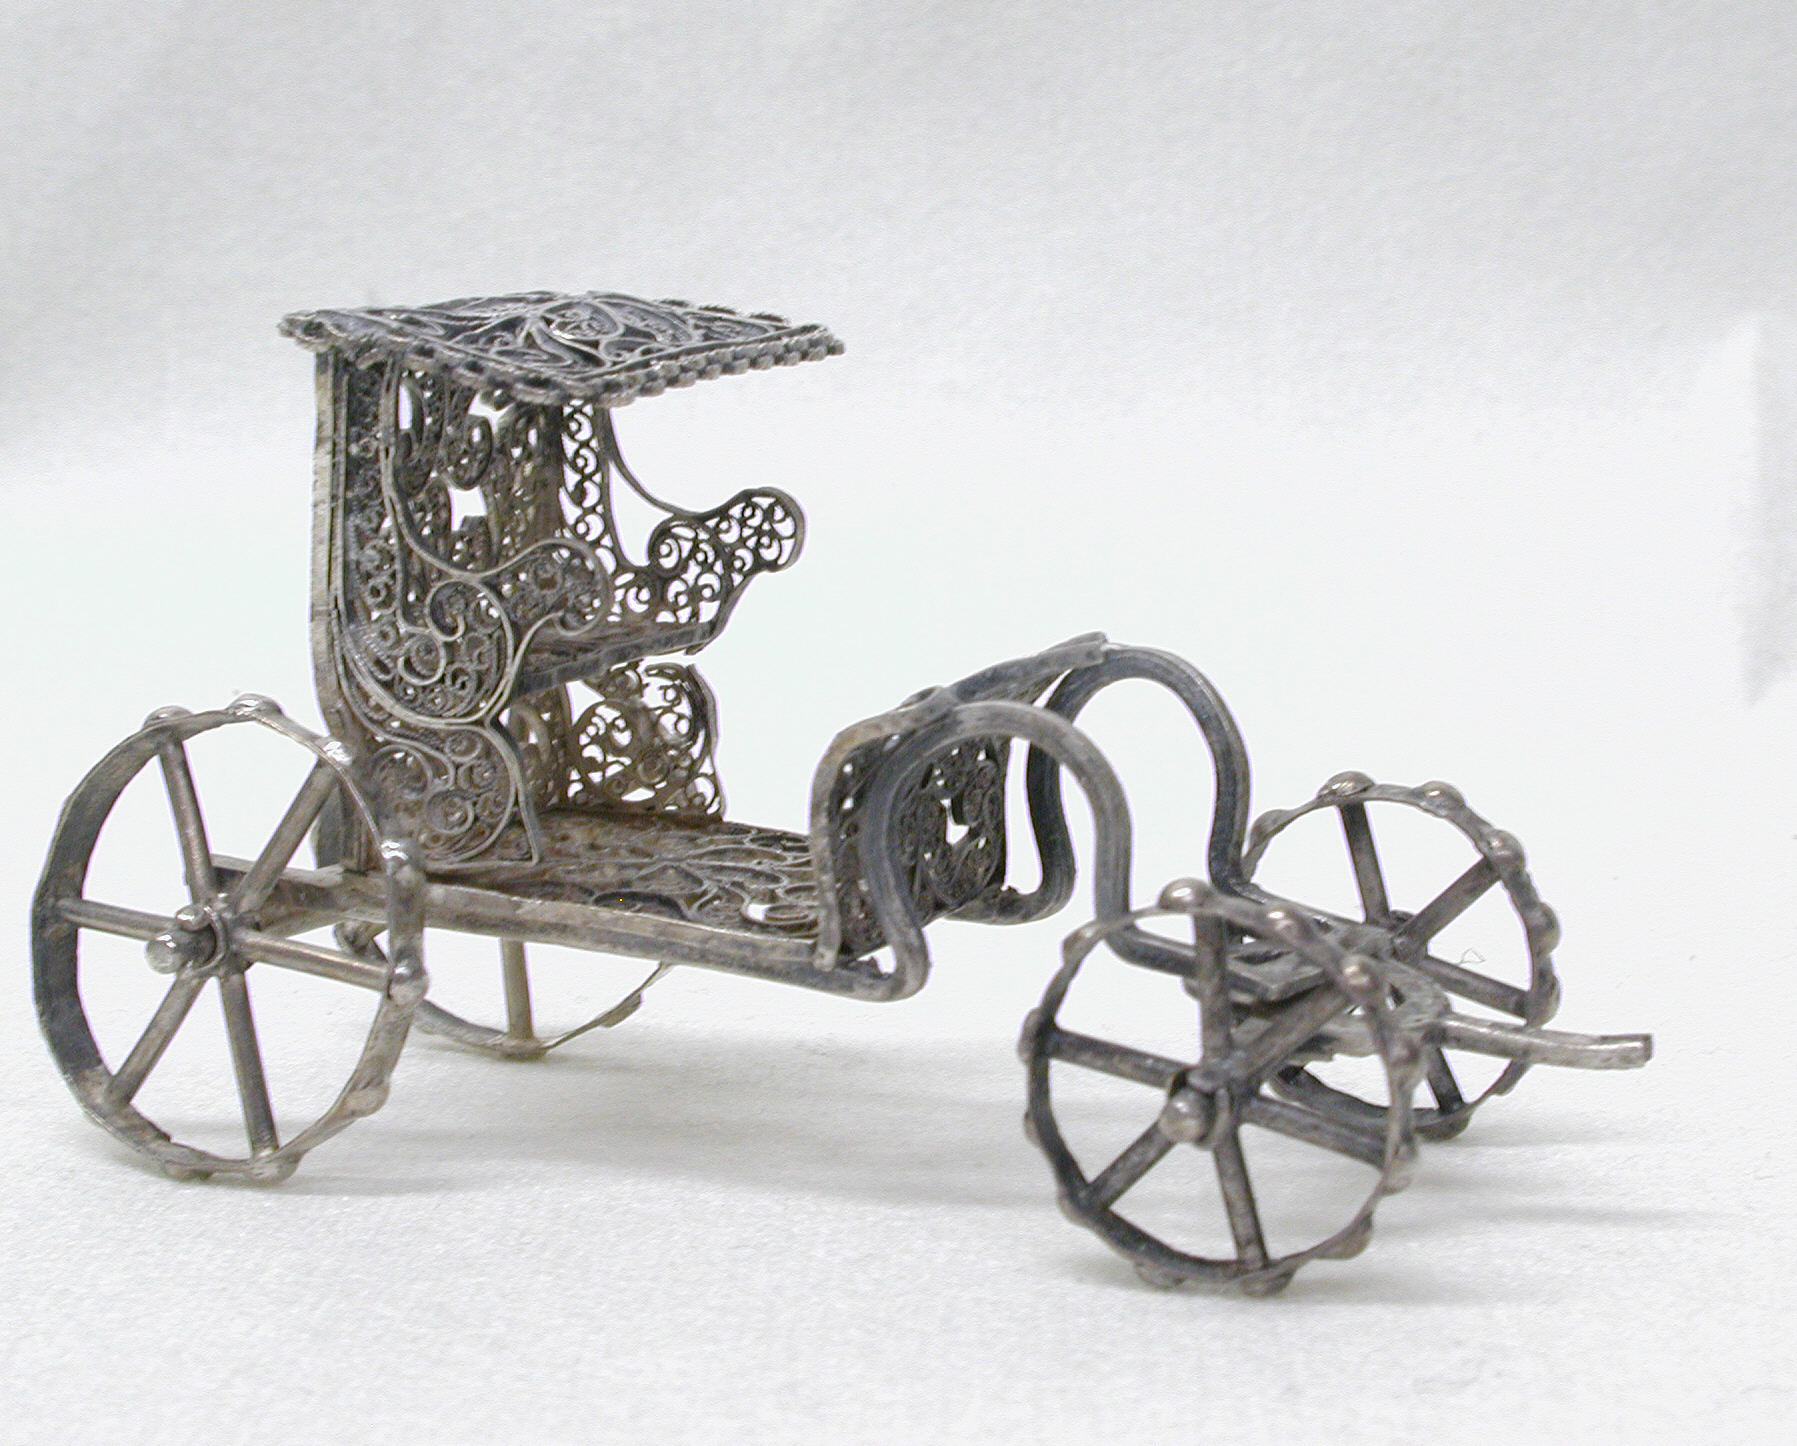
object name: chaise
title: Miniature chaise (part of a set)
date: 1675-1700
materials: silver